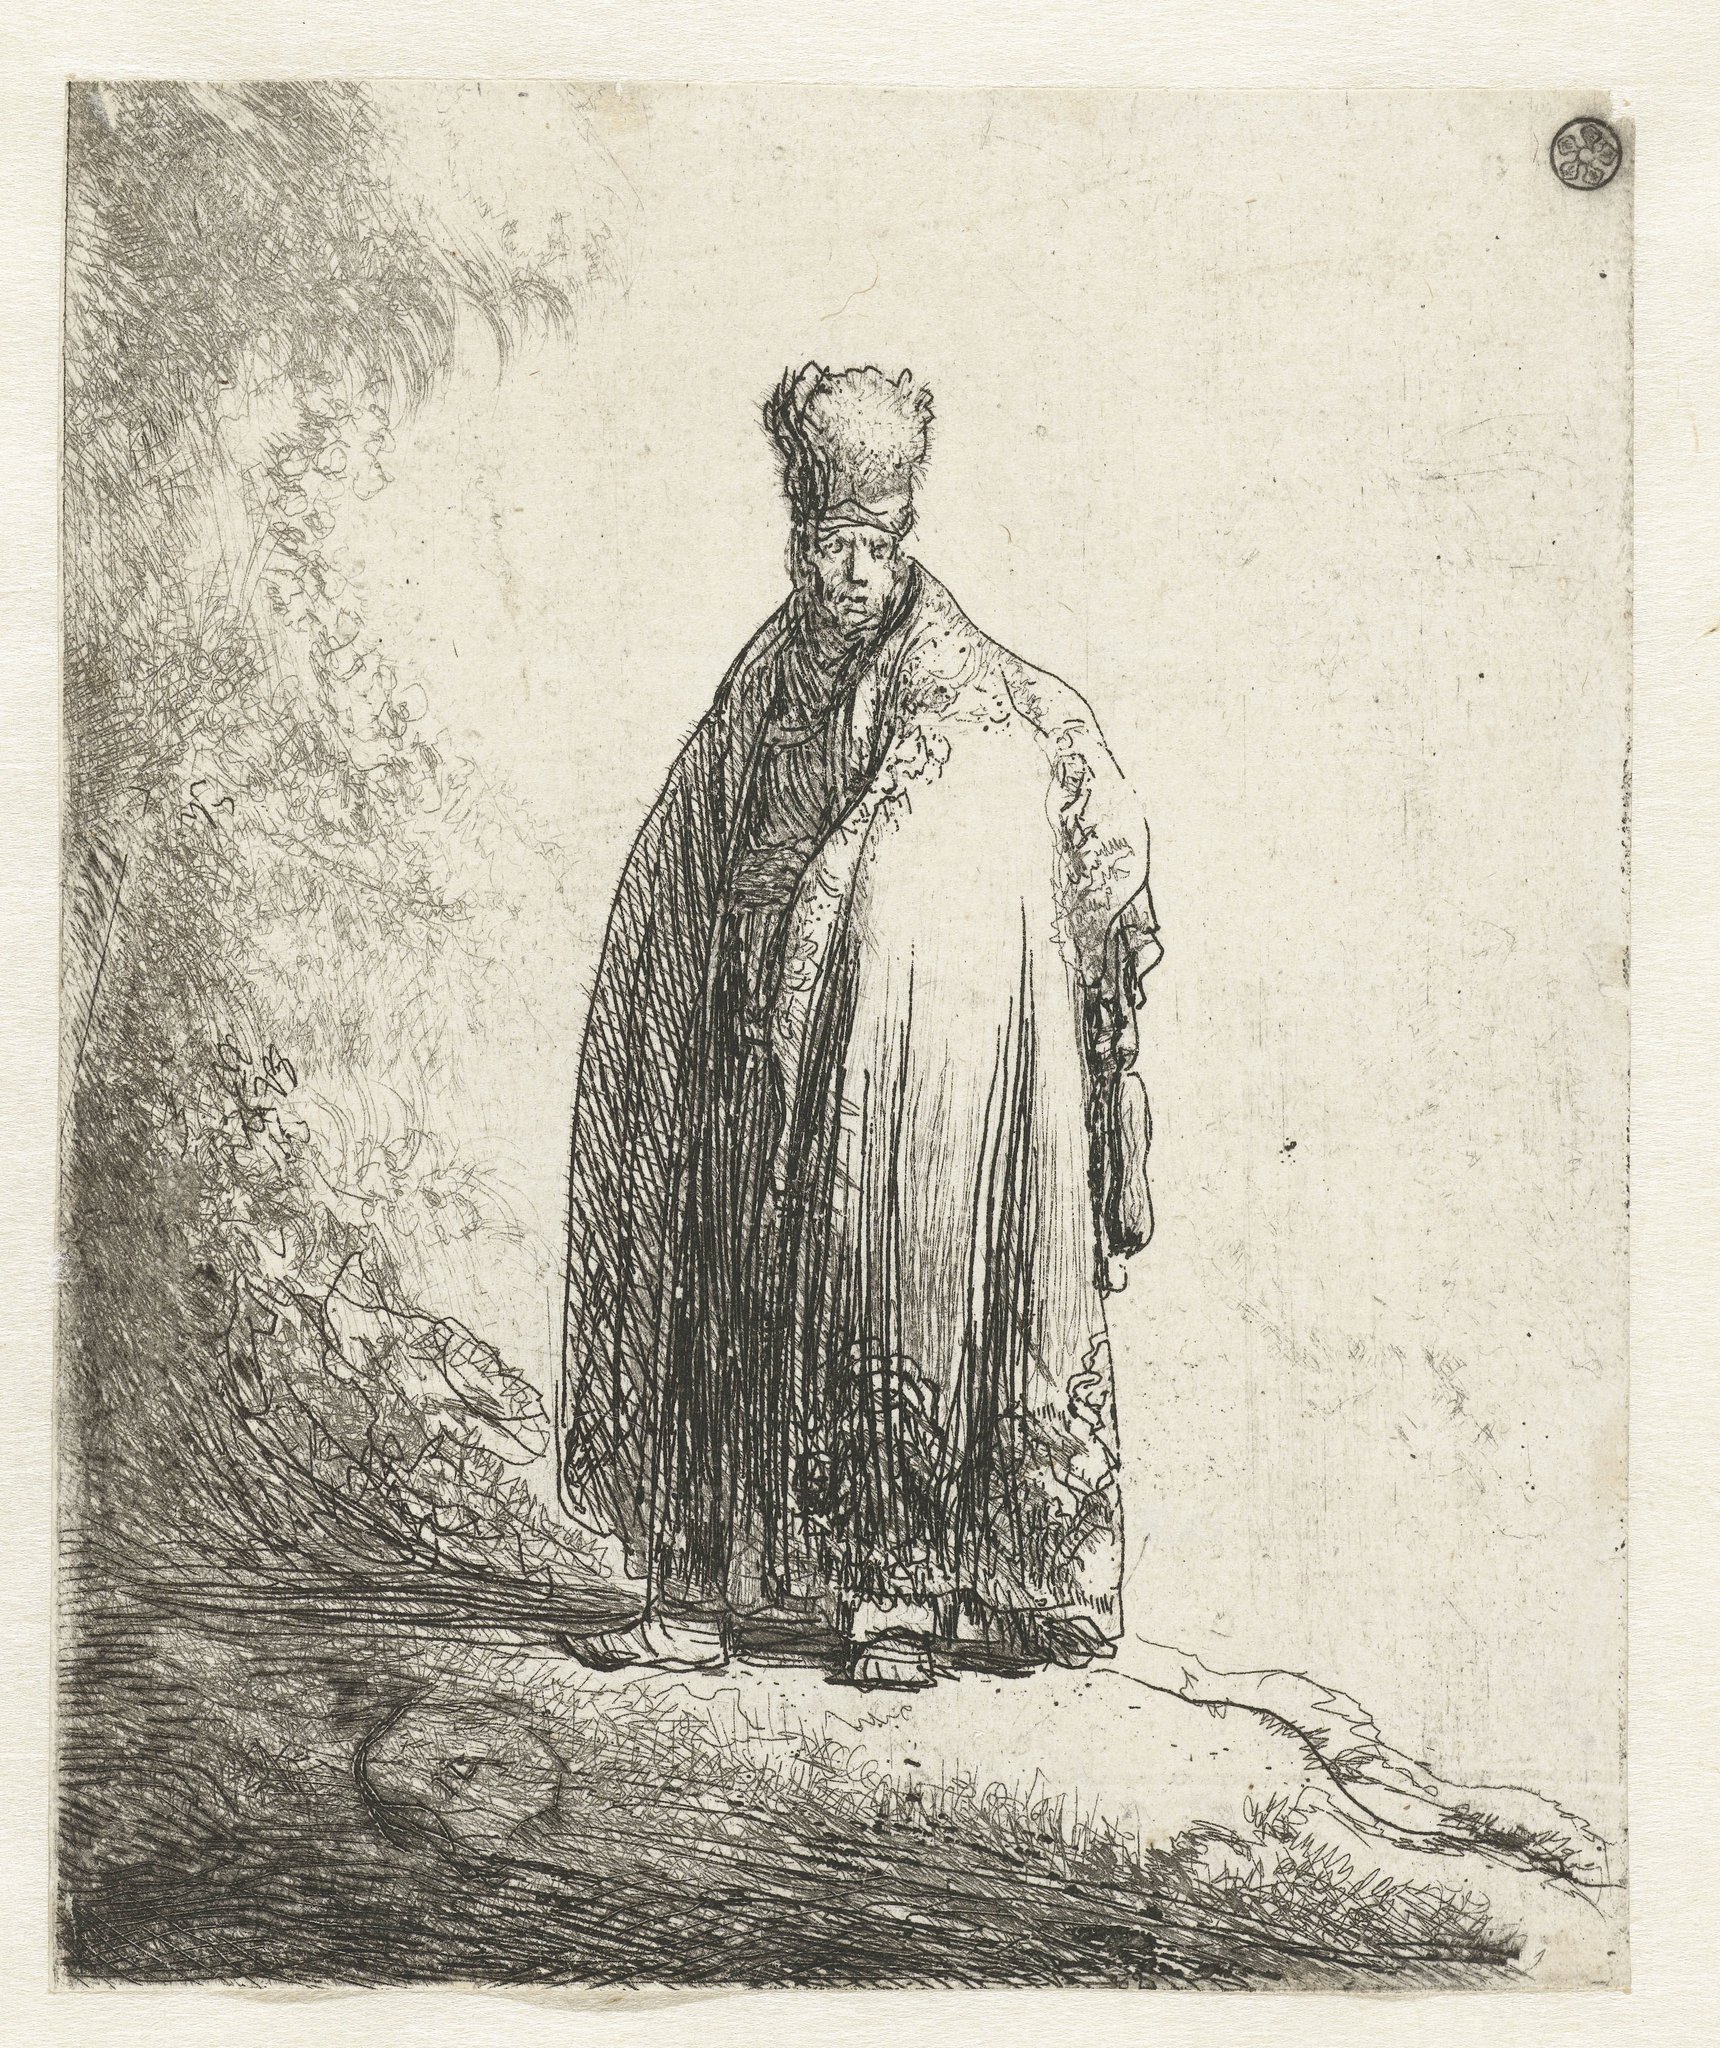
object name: print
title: Staande man in oosterse kleding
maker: jan lievens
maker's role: draughtsman, painter, print maker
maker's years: 1607-1674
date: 1625-1674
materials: paper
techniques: etching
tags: human races; peoples; nationalities (+ costume), male sex; man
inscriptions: collector's mark: Lugt 2775, collector's mark: Lugt 240